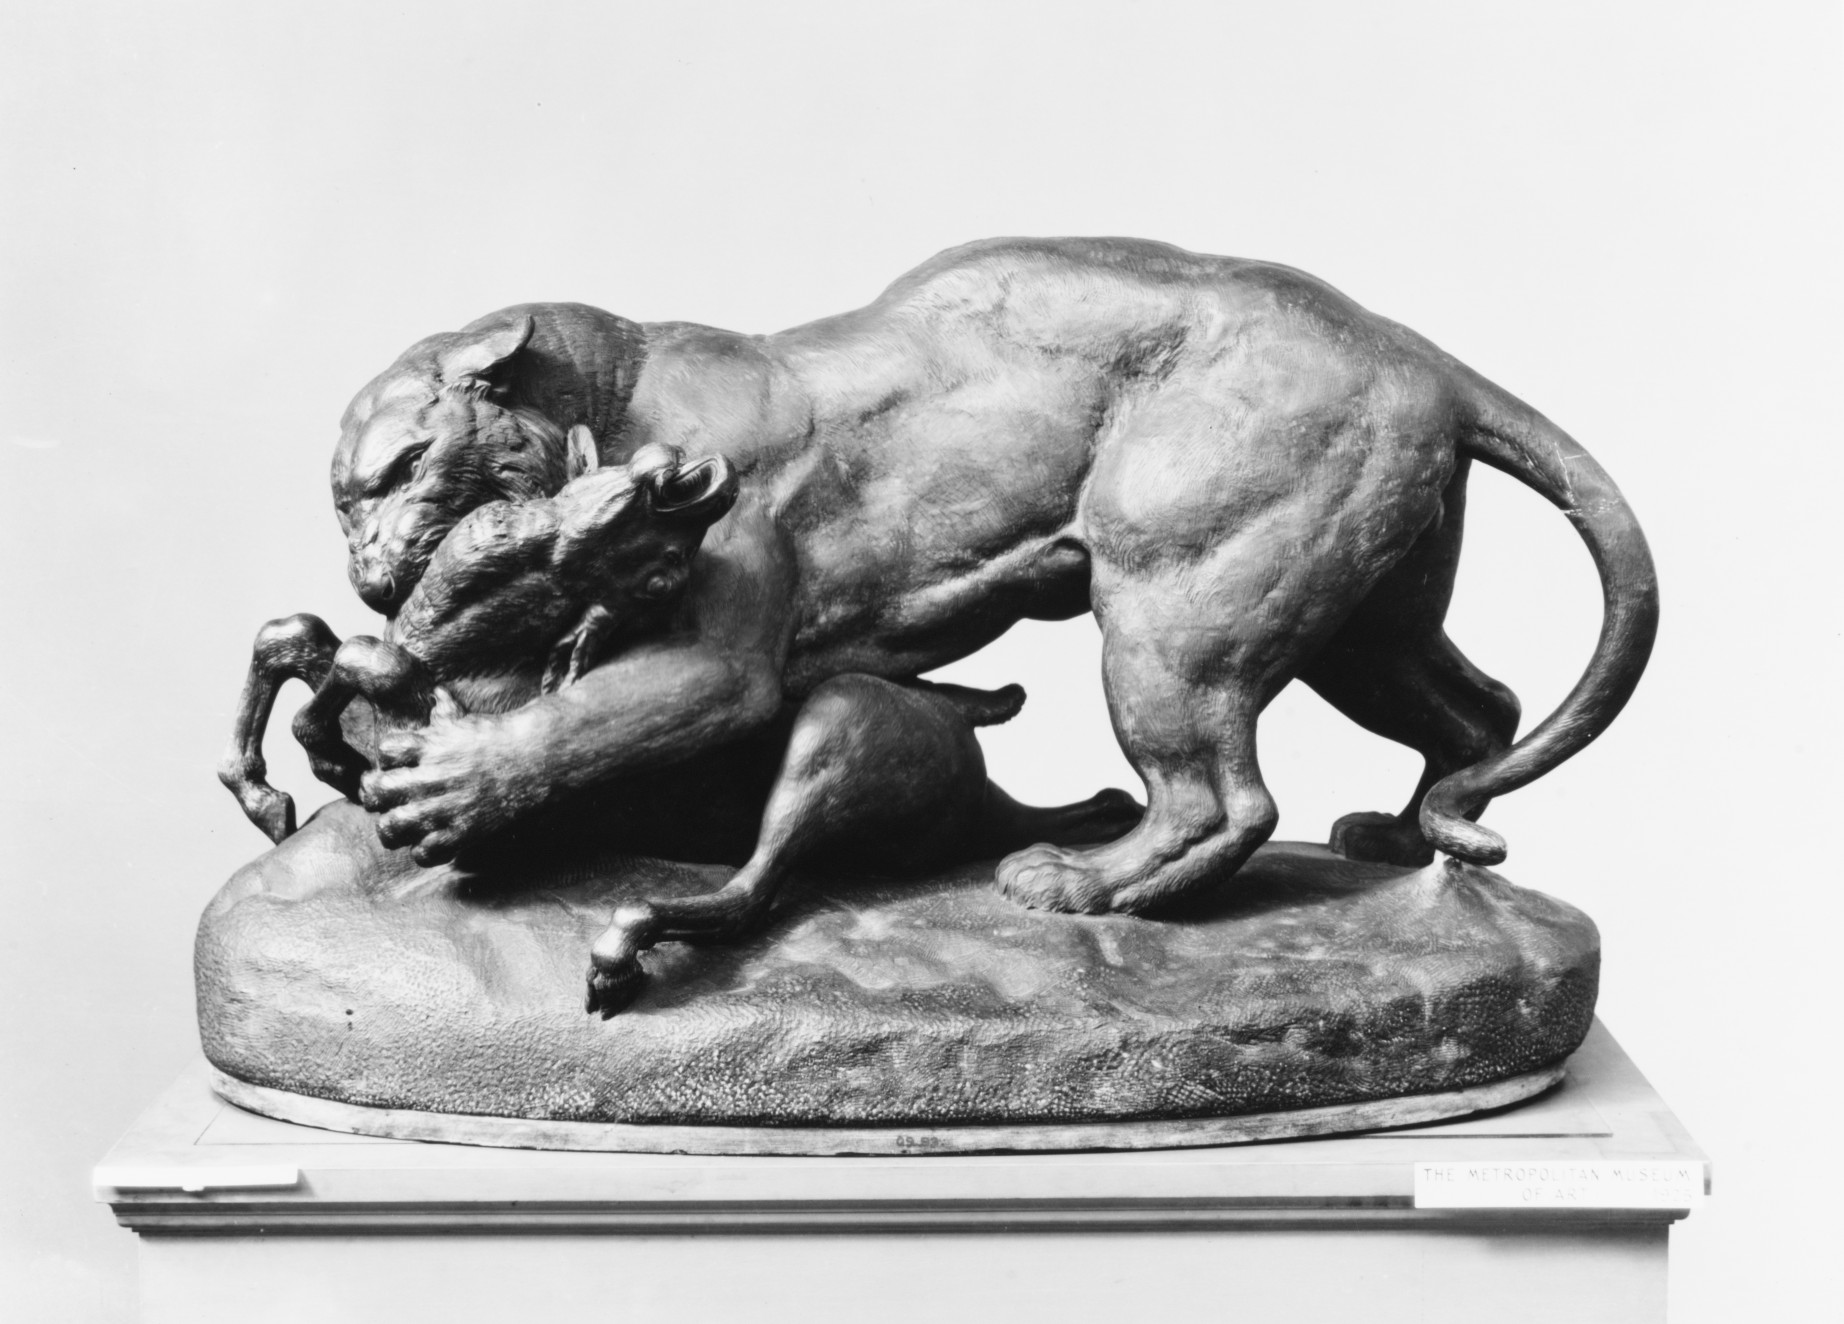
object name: group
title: Tiger attacking an antelope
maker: antoine-louis barye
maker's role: artist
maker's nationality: french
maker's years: 1795-1875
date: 1801-1900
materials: stone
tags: hunting,tigers